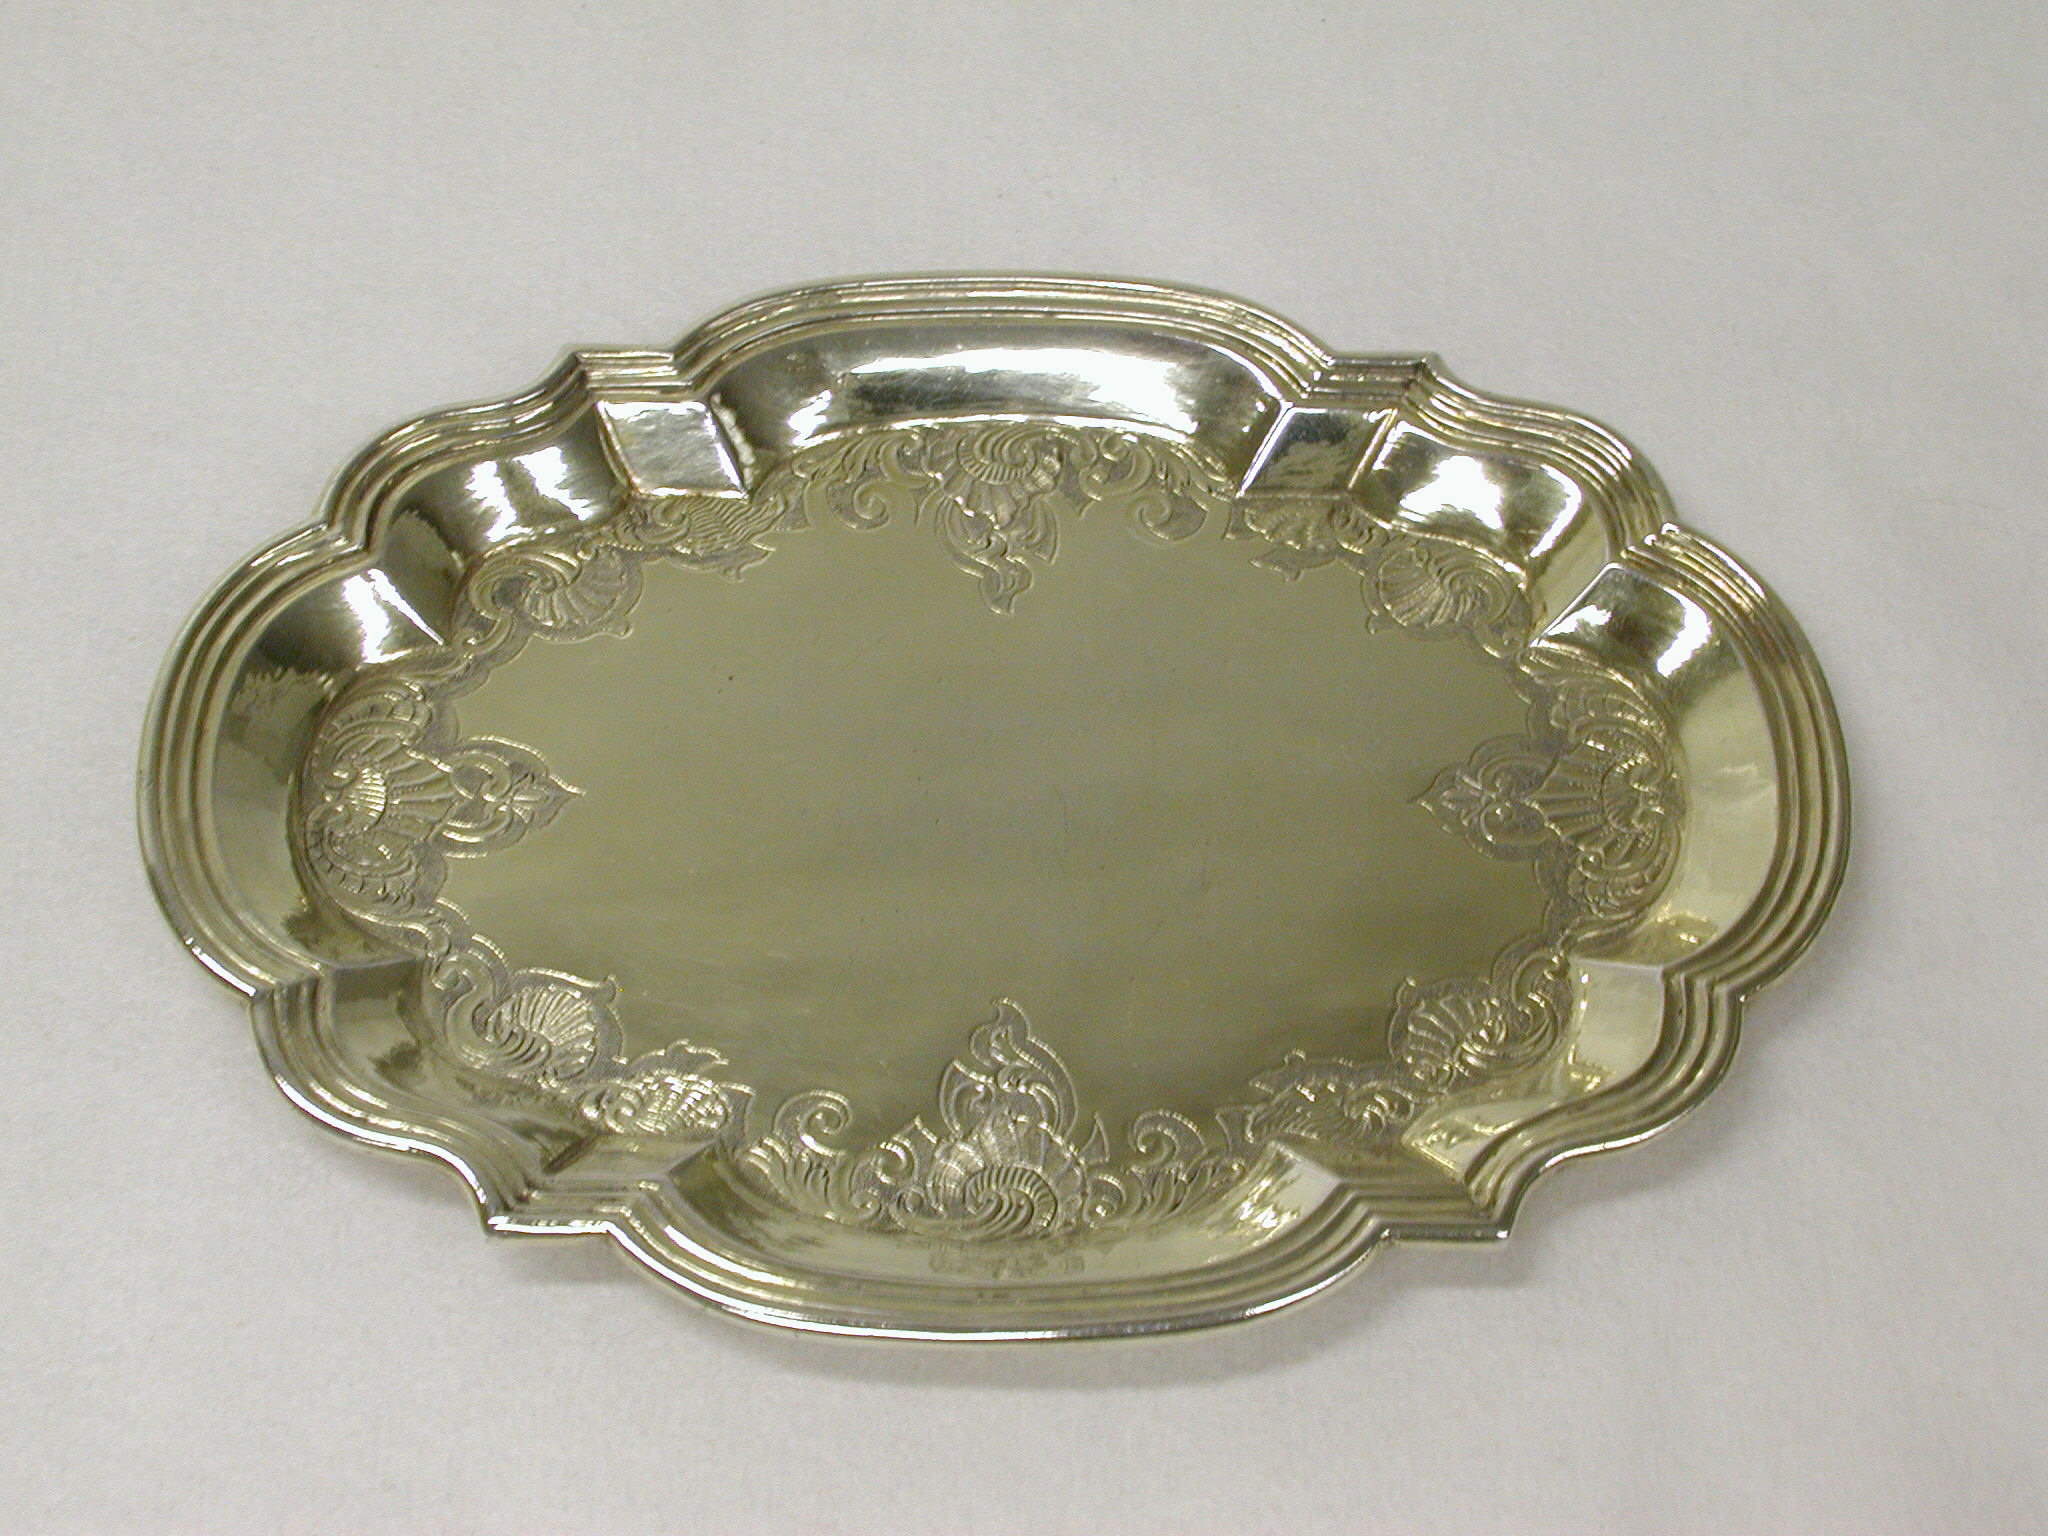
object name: tray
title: Tray (one of a pair)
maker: johann conrad lotter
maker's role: maker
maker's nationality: german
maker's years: 1738-1779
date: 1743-1745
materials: silver gilt